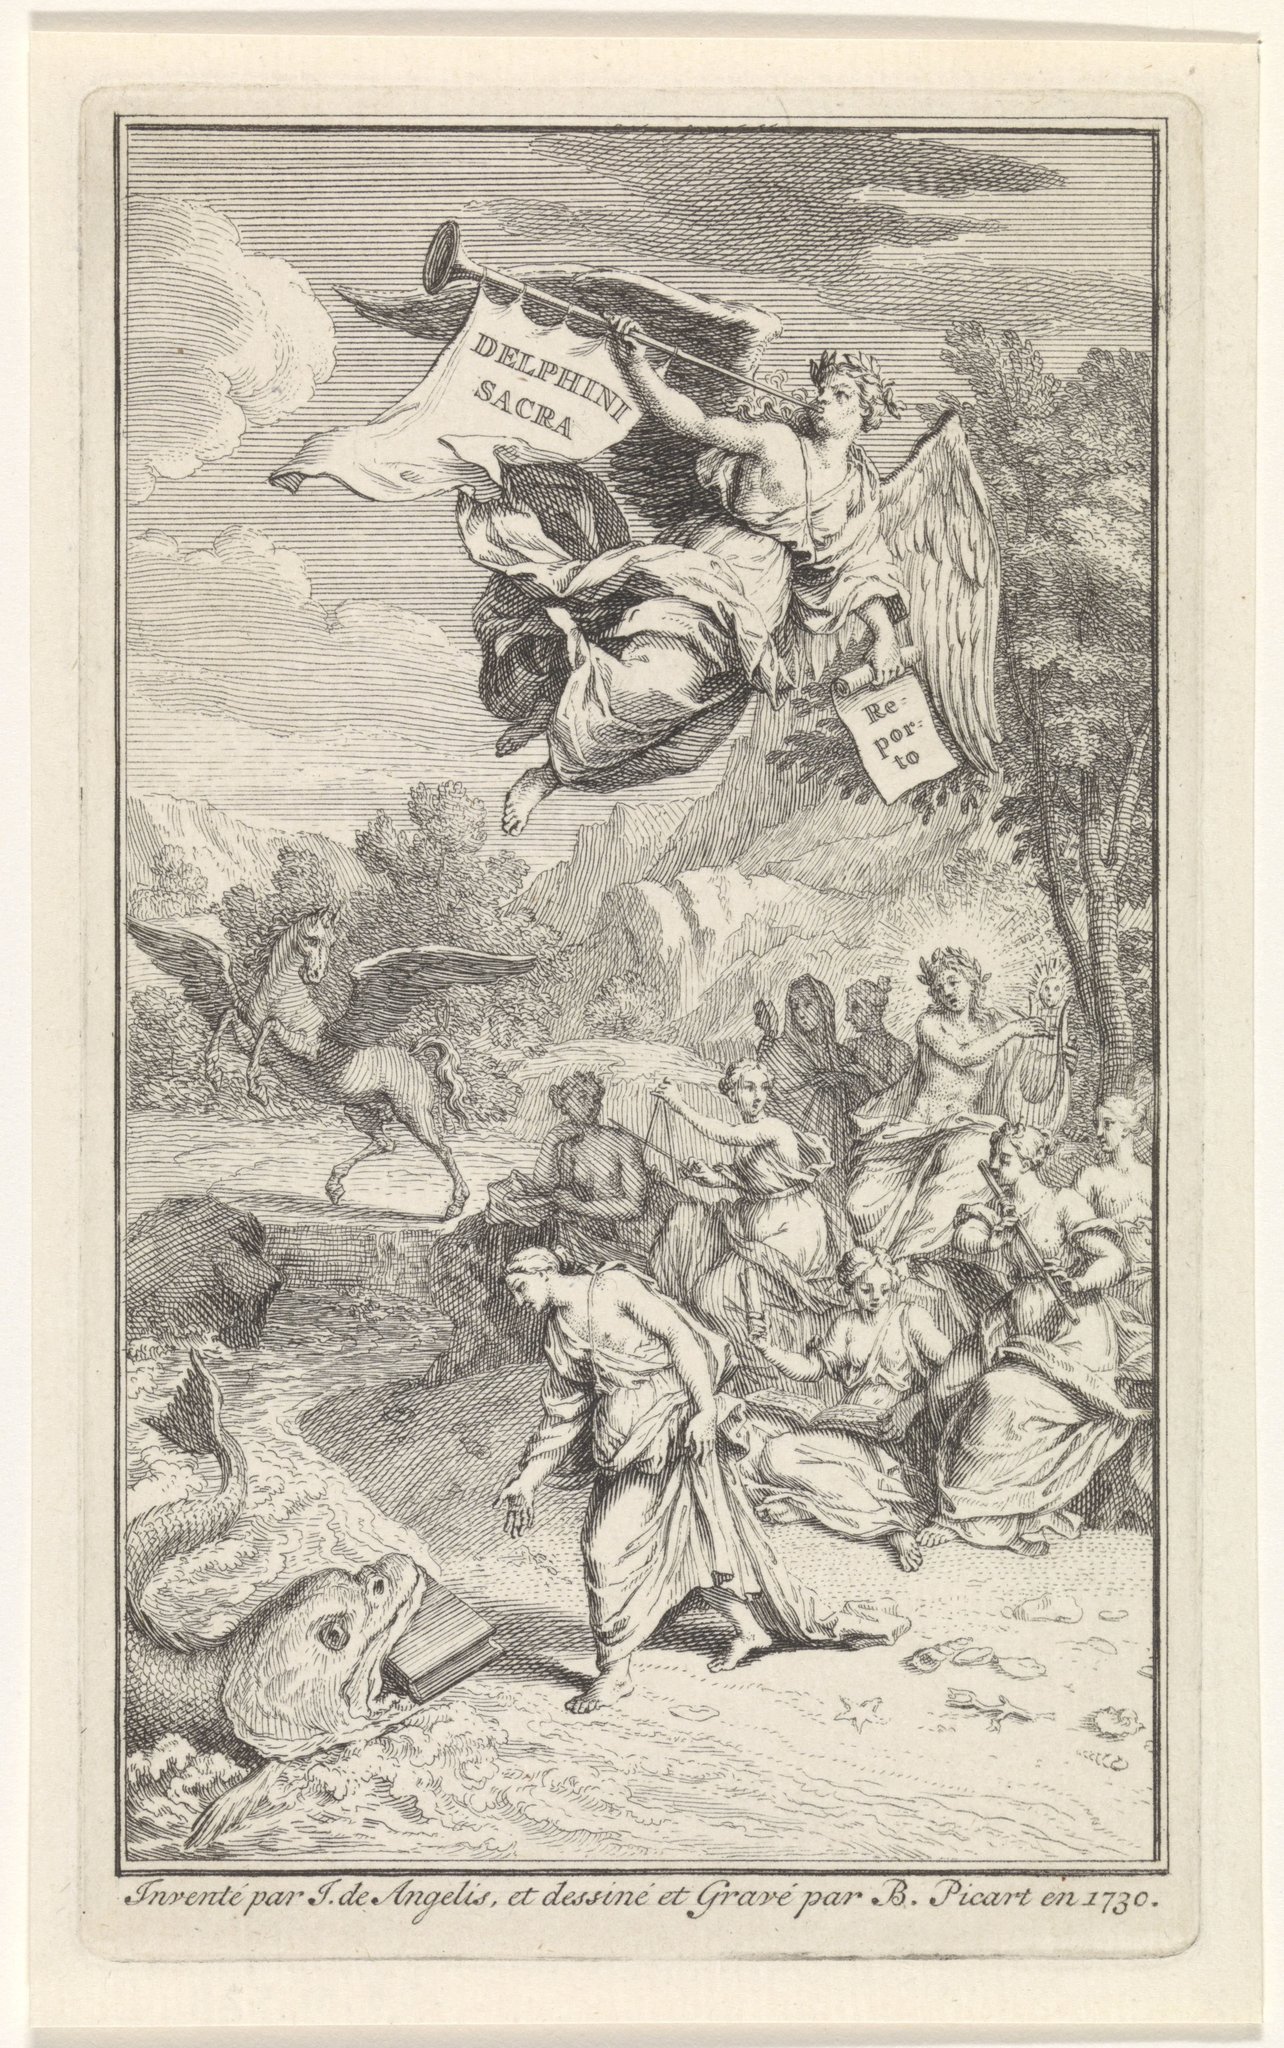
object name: print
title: Titelpagina voor: Giovanni Delfino, Parnaso del' Em mo Cardinal Delfino, 1730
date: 1730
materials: paper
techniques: engraving, etching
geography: amsterdam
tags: pegasus, the winged horse, apollo and the muses, apollo musagetes, swimming mammals: dolphin, fame; 'fama', 'fama buona', 'fama chiara' (ripa)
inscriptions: collector's mark: Lugt 2228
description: Apollo met zijn lier te midden van de Muzen op de Parnassus. Een van de Muzen staat op het strand en ontvangt een boek uit de bek van een dolfijn. Op de achtergrond het gevleugelde paard Pegasus. In de lucht vliegt Faam. Titelpagina voor het boek Parnaso (Parnassus) van de schrijver en kardinaal Giovanni Delfino, wiens achternaam dolfijn betekent.